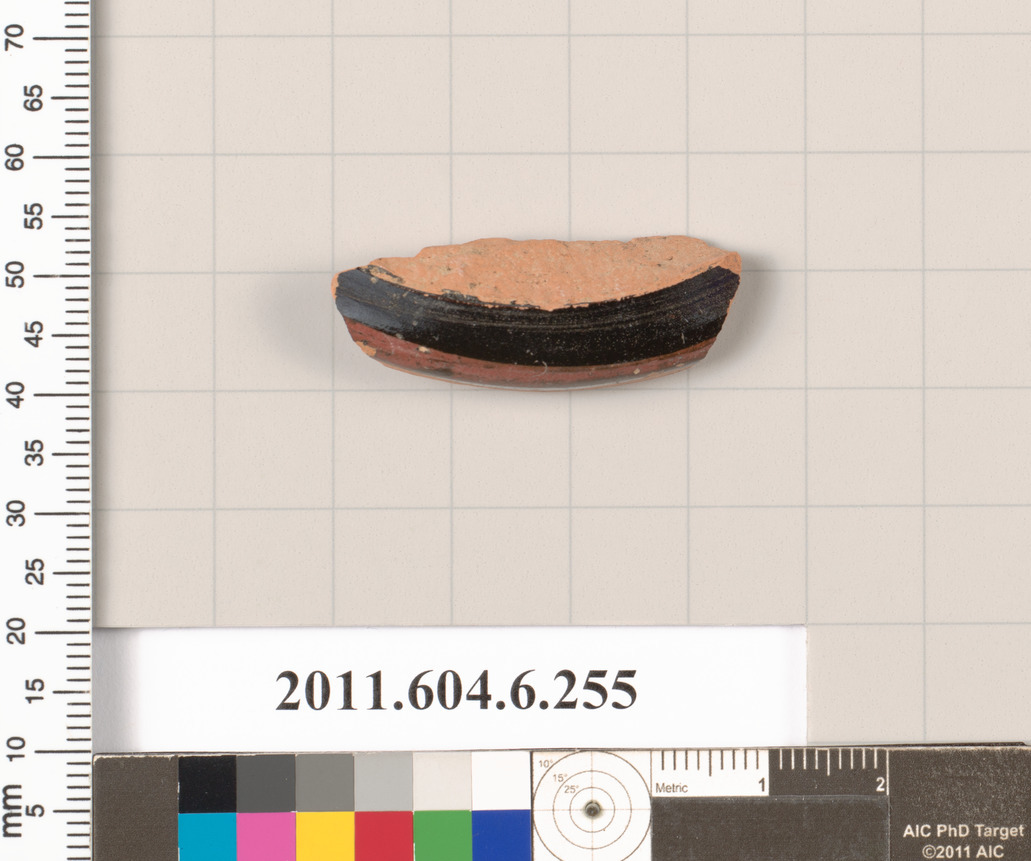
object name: undetermined shape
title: Terracotta fragment of an undetermined shape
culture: greek, attic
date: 600-401 BCE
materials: terracotta